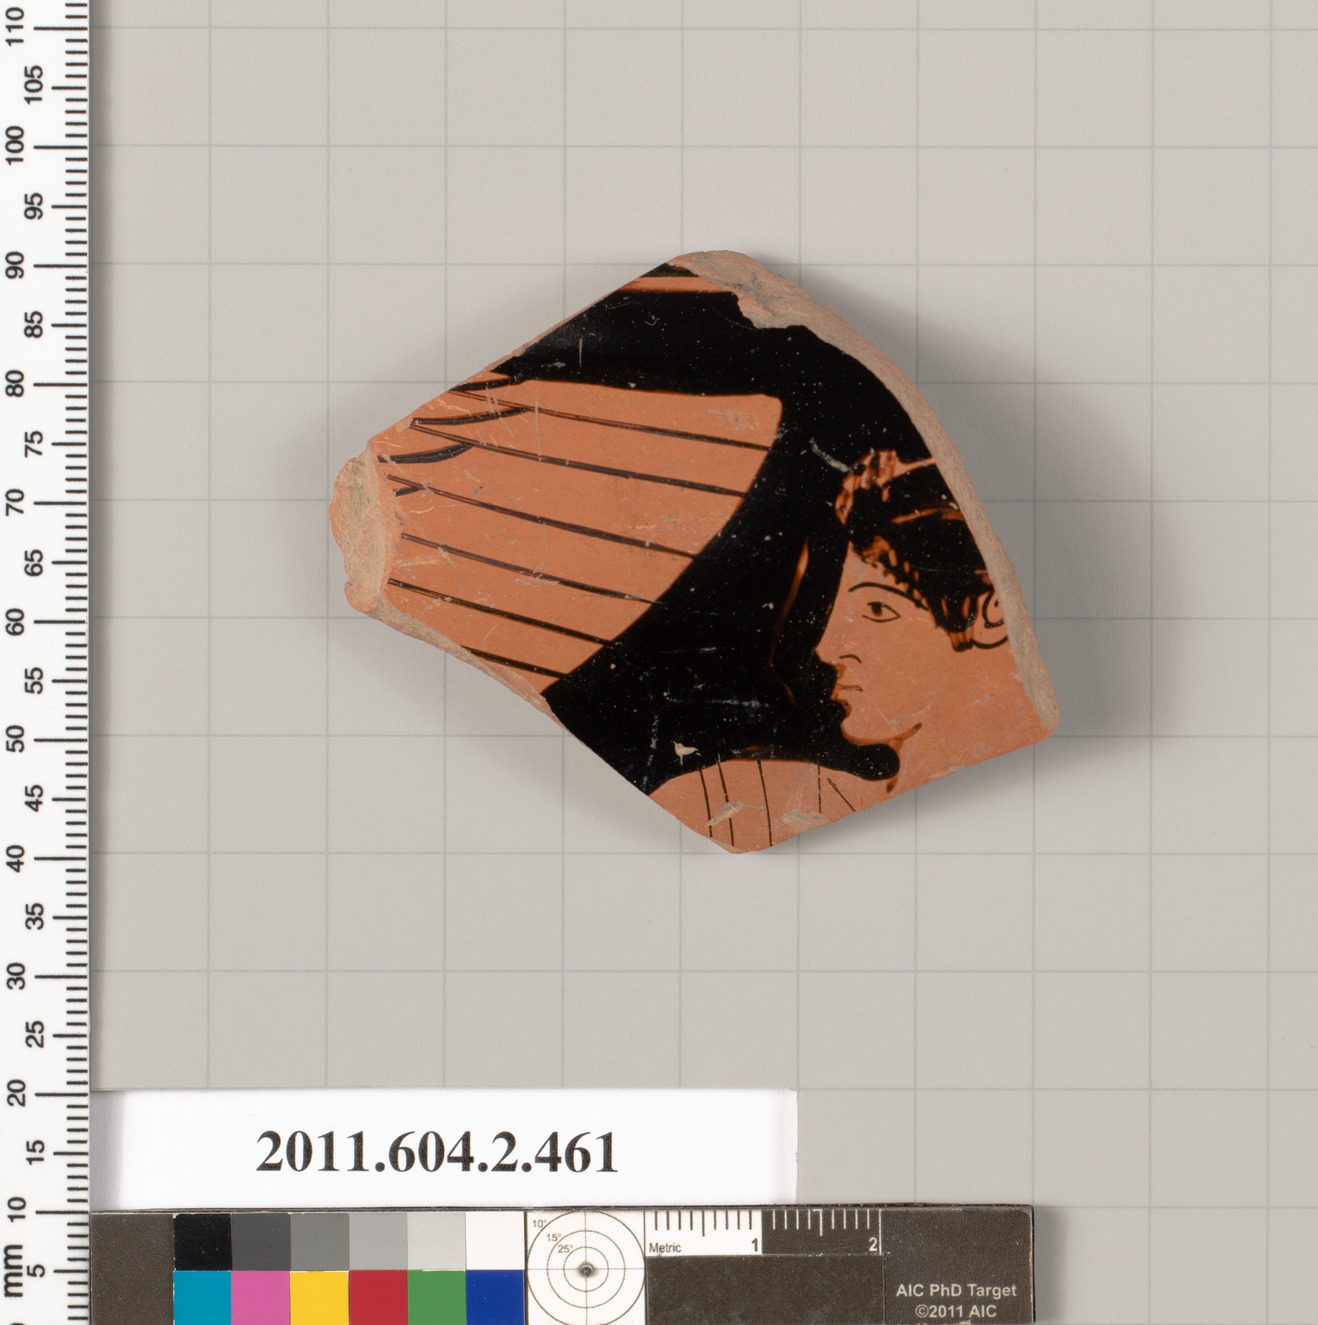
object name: column krater fragment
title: Terracotta fragment of a column-krater (bowl for mixing wine and water)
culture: greek, attic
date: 460-440 BCE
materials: terracotta